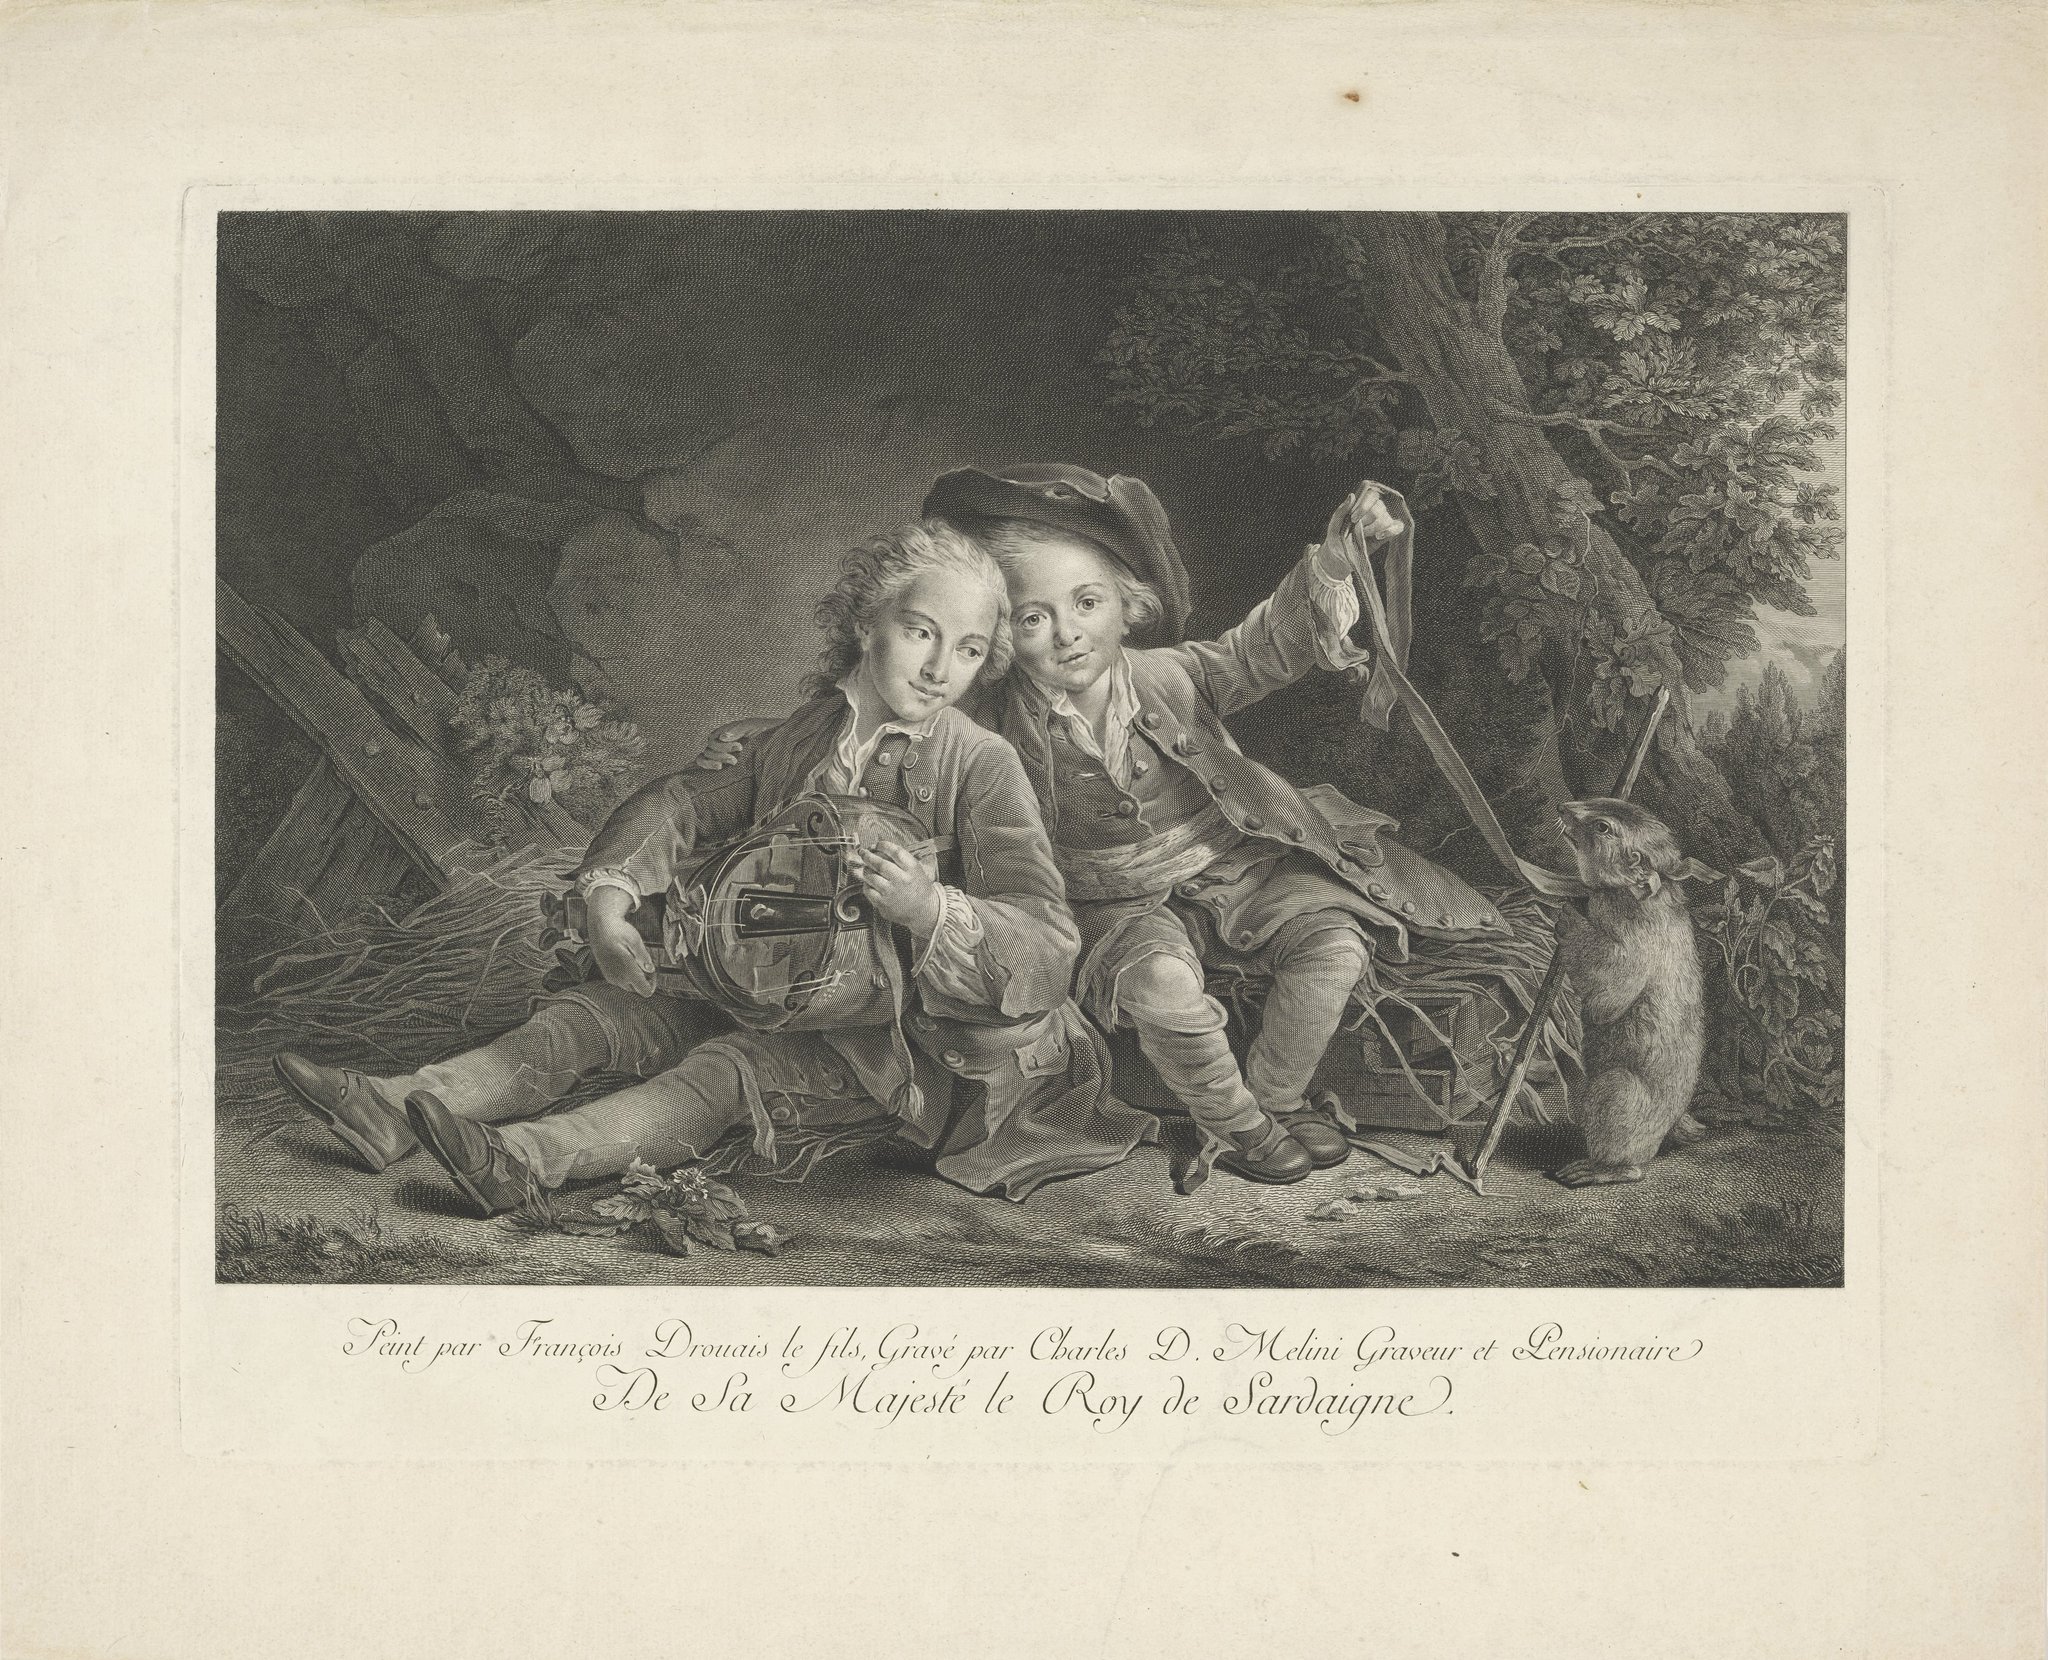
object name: print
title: Twee jongens met marmot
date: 1750-1795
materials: paper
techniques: engraving, etching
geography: italy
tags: earning money with guinea-pig, child playing with animals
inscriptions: collector's mark: Lugt 2228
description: Twee jongens met een marmot in een landschap. Tweeregelige Franse tekst in ondermarge.